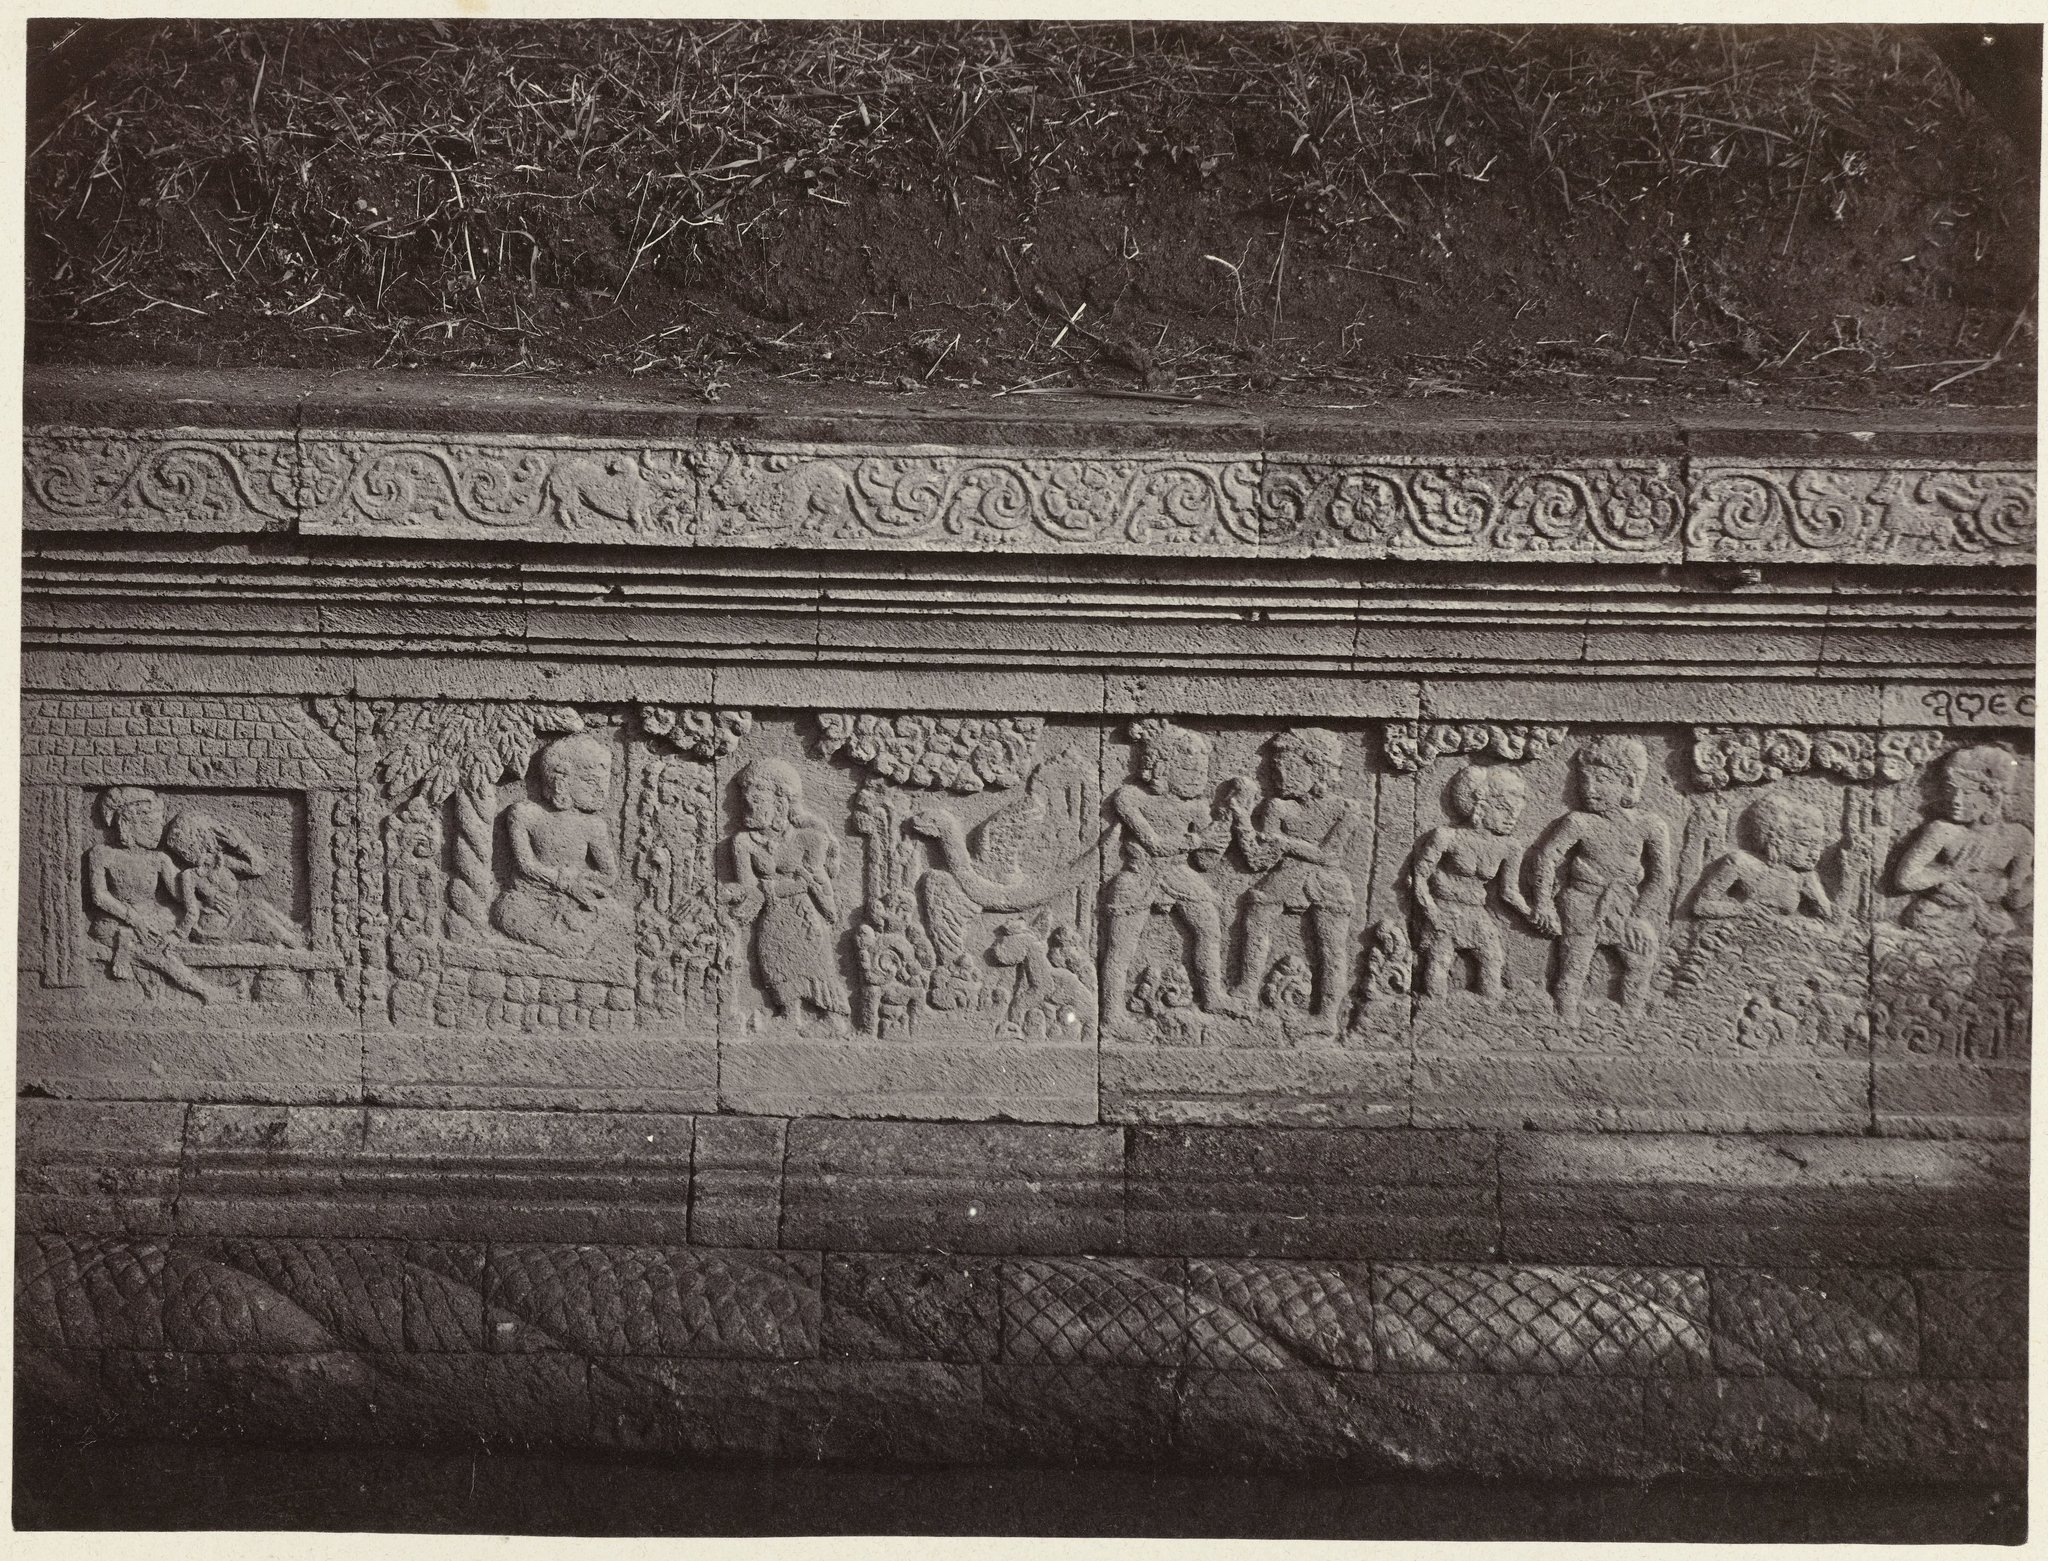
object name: photograph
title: Reliëf op het voetstuk van een pendopo aan de oostzijde van Candi Panataran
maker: isidore kinsbergen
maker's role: fotograaf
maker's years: 1821-1905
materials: cardboard, paper, photographic support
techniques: albumen print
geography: java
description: Candi Panataran (Temple Complex), Pendopo terrace, reliefs 4-10 ('Sang Satyawan' story), east side. Panataran, Blitar district, East Java province 1375 AD.